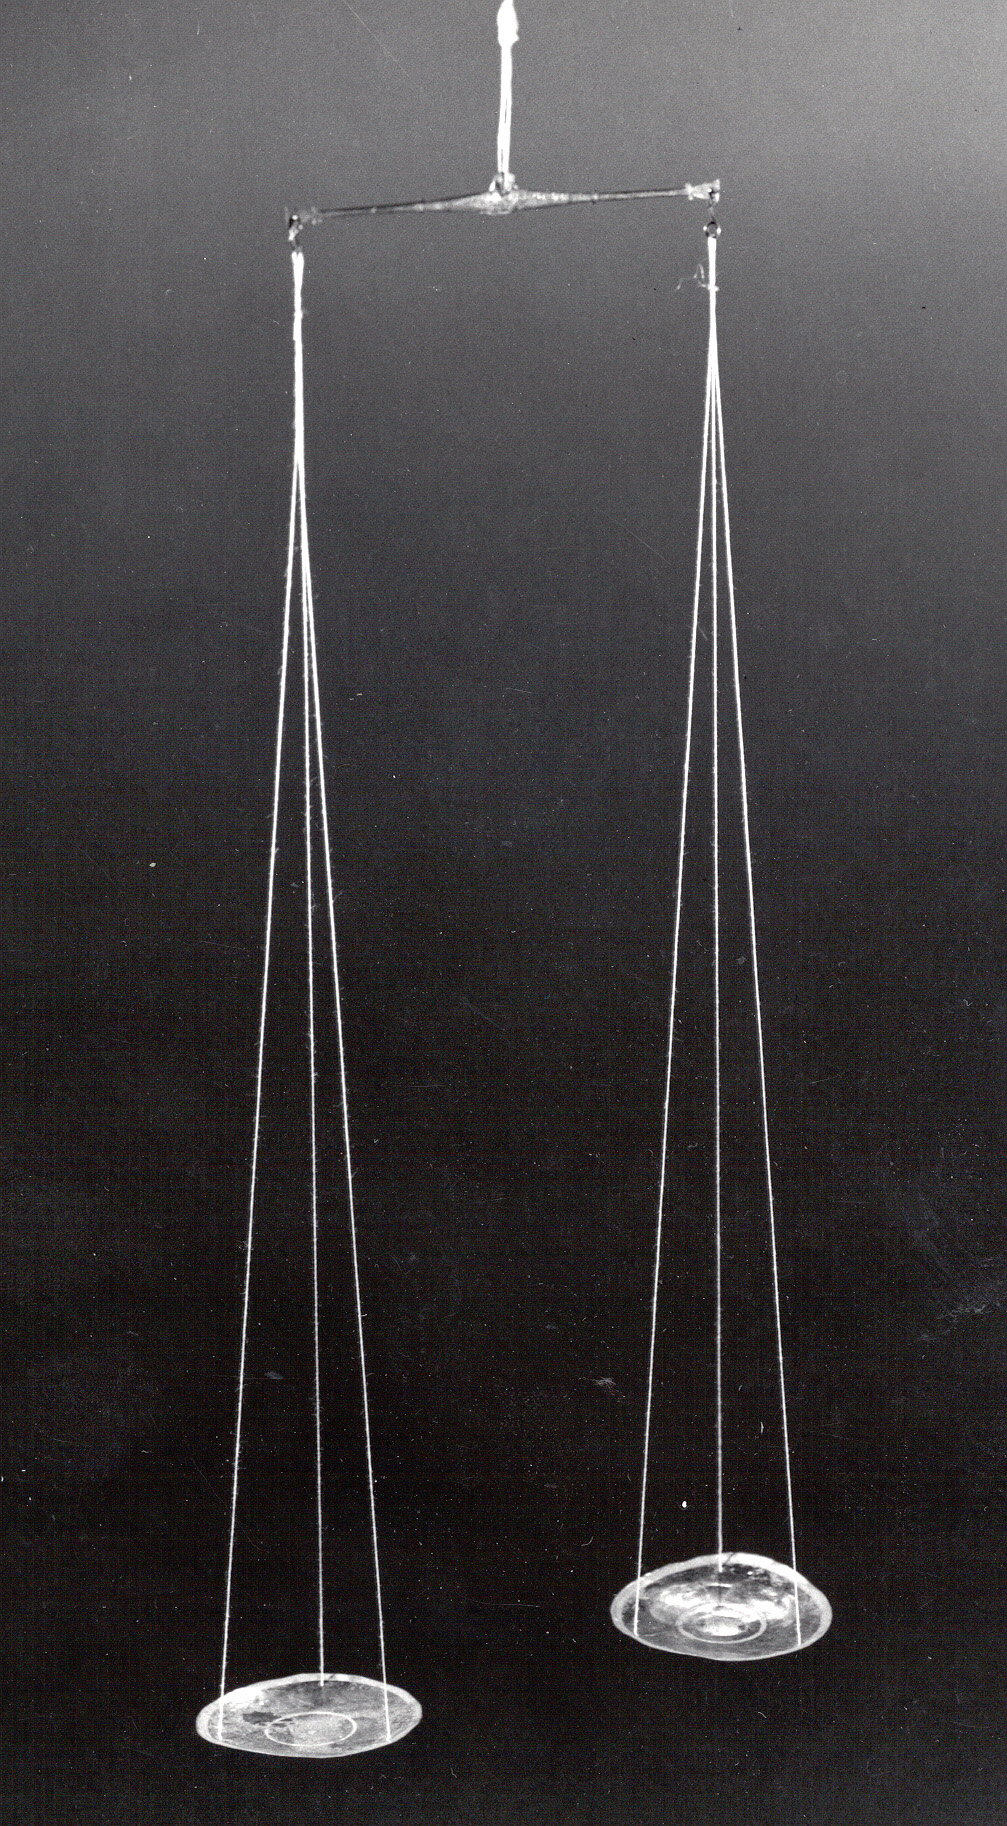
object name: scale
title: Scale for Gold Measurement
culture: akan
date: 1801-1900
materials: brass, pigment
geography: côte d'ivoire